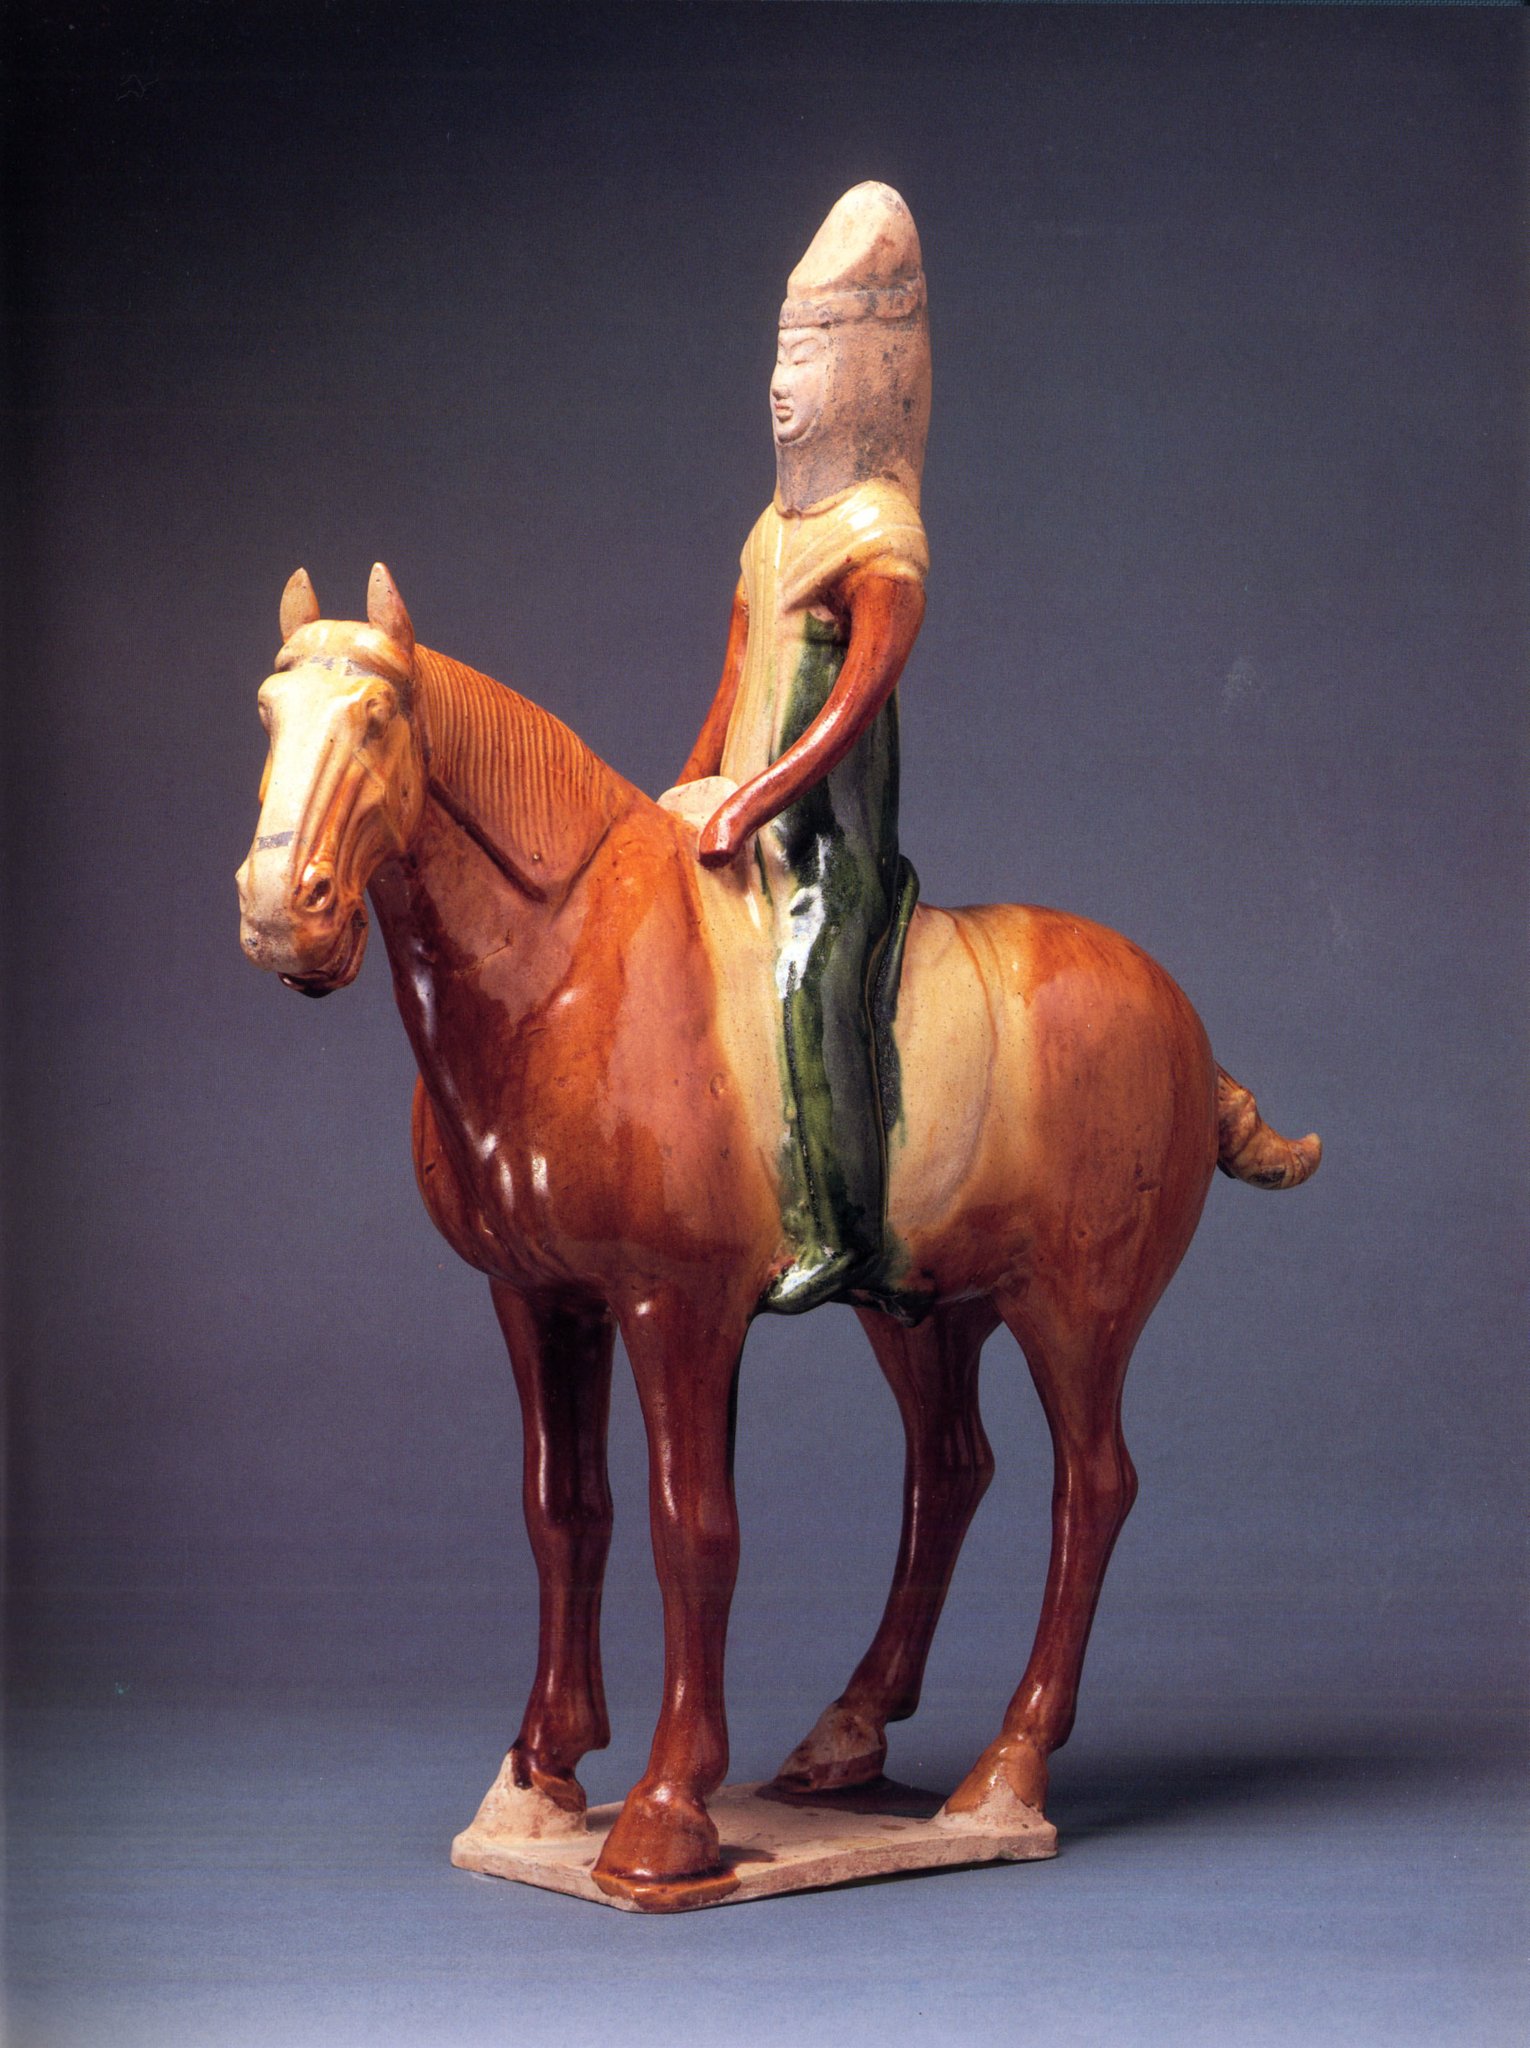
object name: figure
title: Horse and female rider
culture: chinese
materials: earthenware, glaze, pigment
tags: women,horses